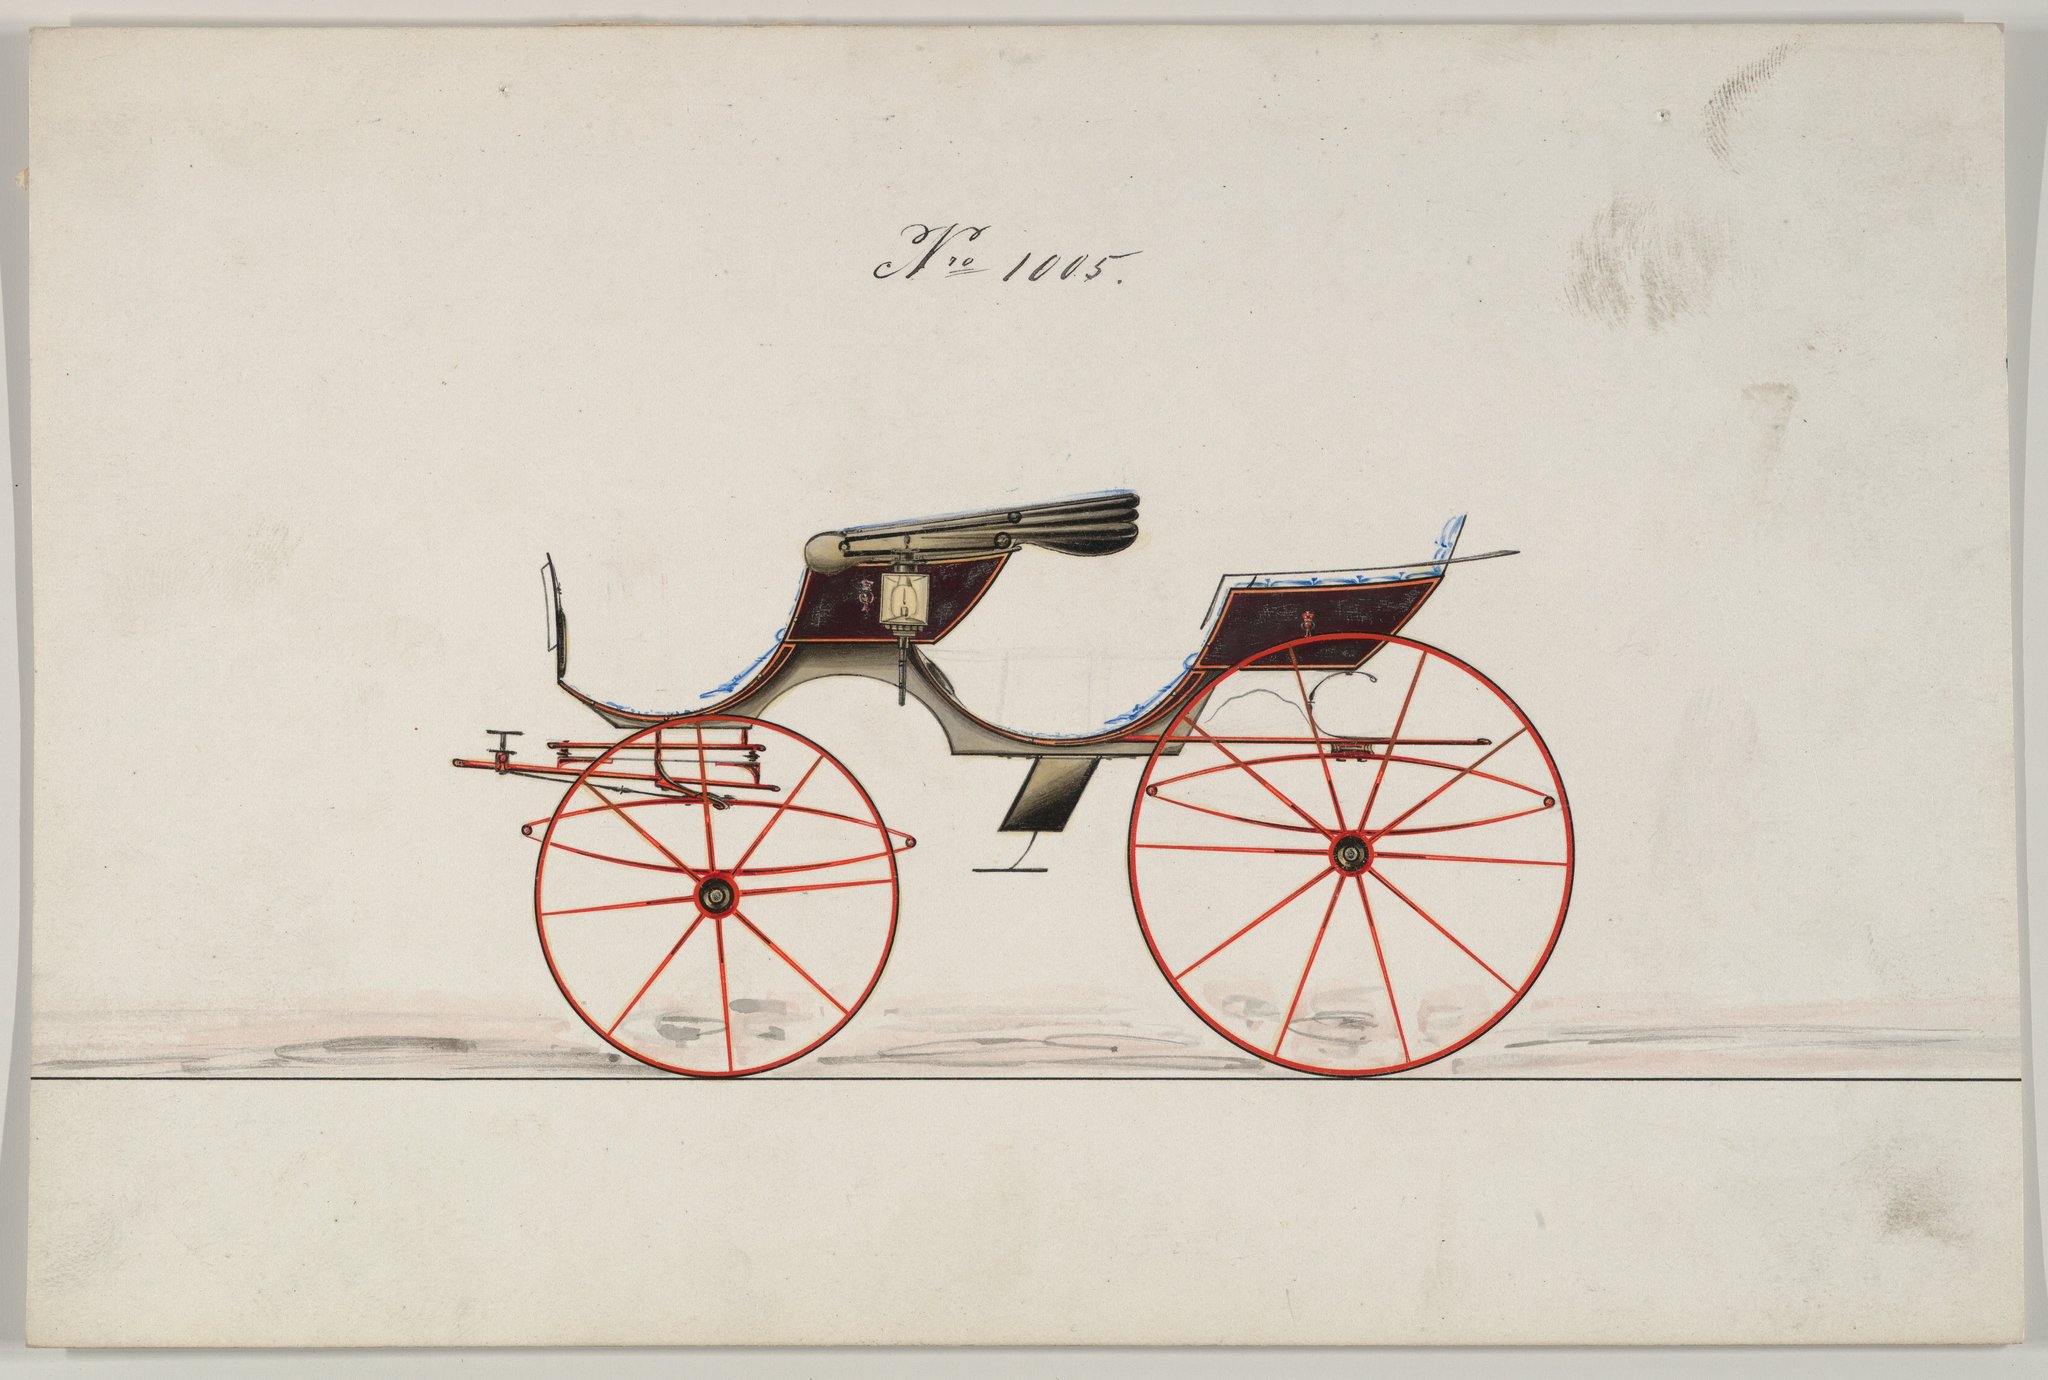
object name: drawing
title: Design for Phaeton, with top, no. 1005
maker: brewster & co.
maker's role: manufacturer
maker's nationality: american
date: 1850-1874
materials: gouache, gum arabic, ink, watercolor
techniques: pen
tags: carriages